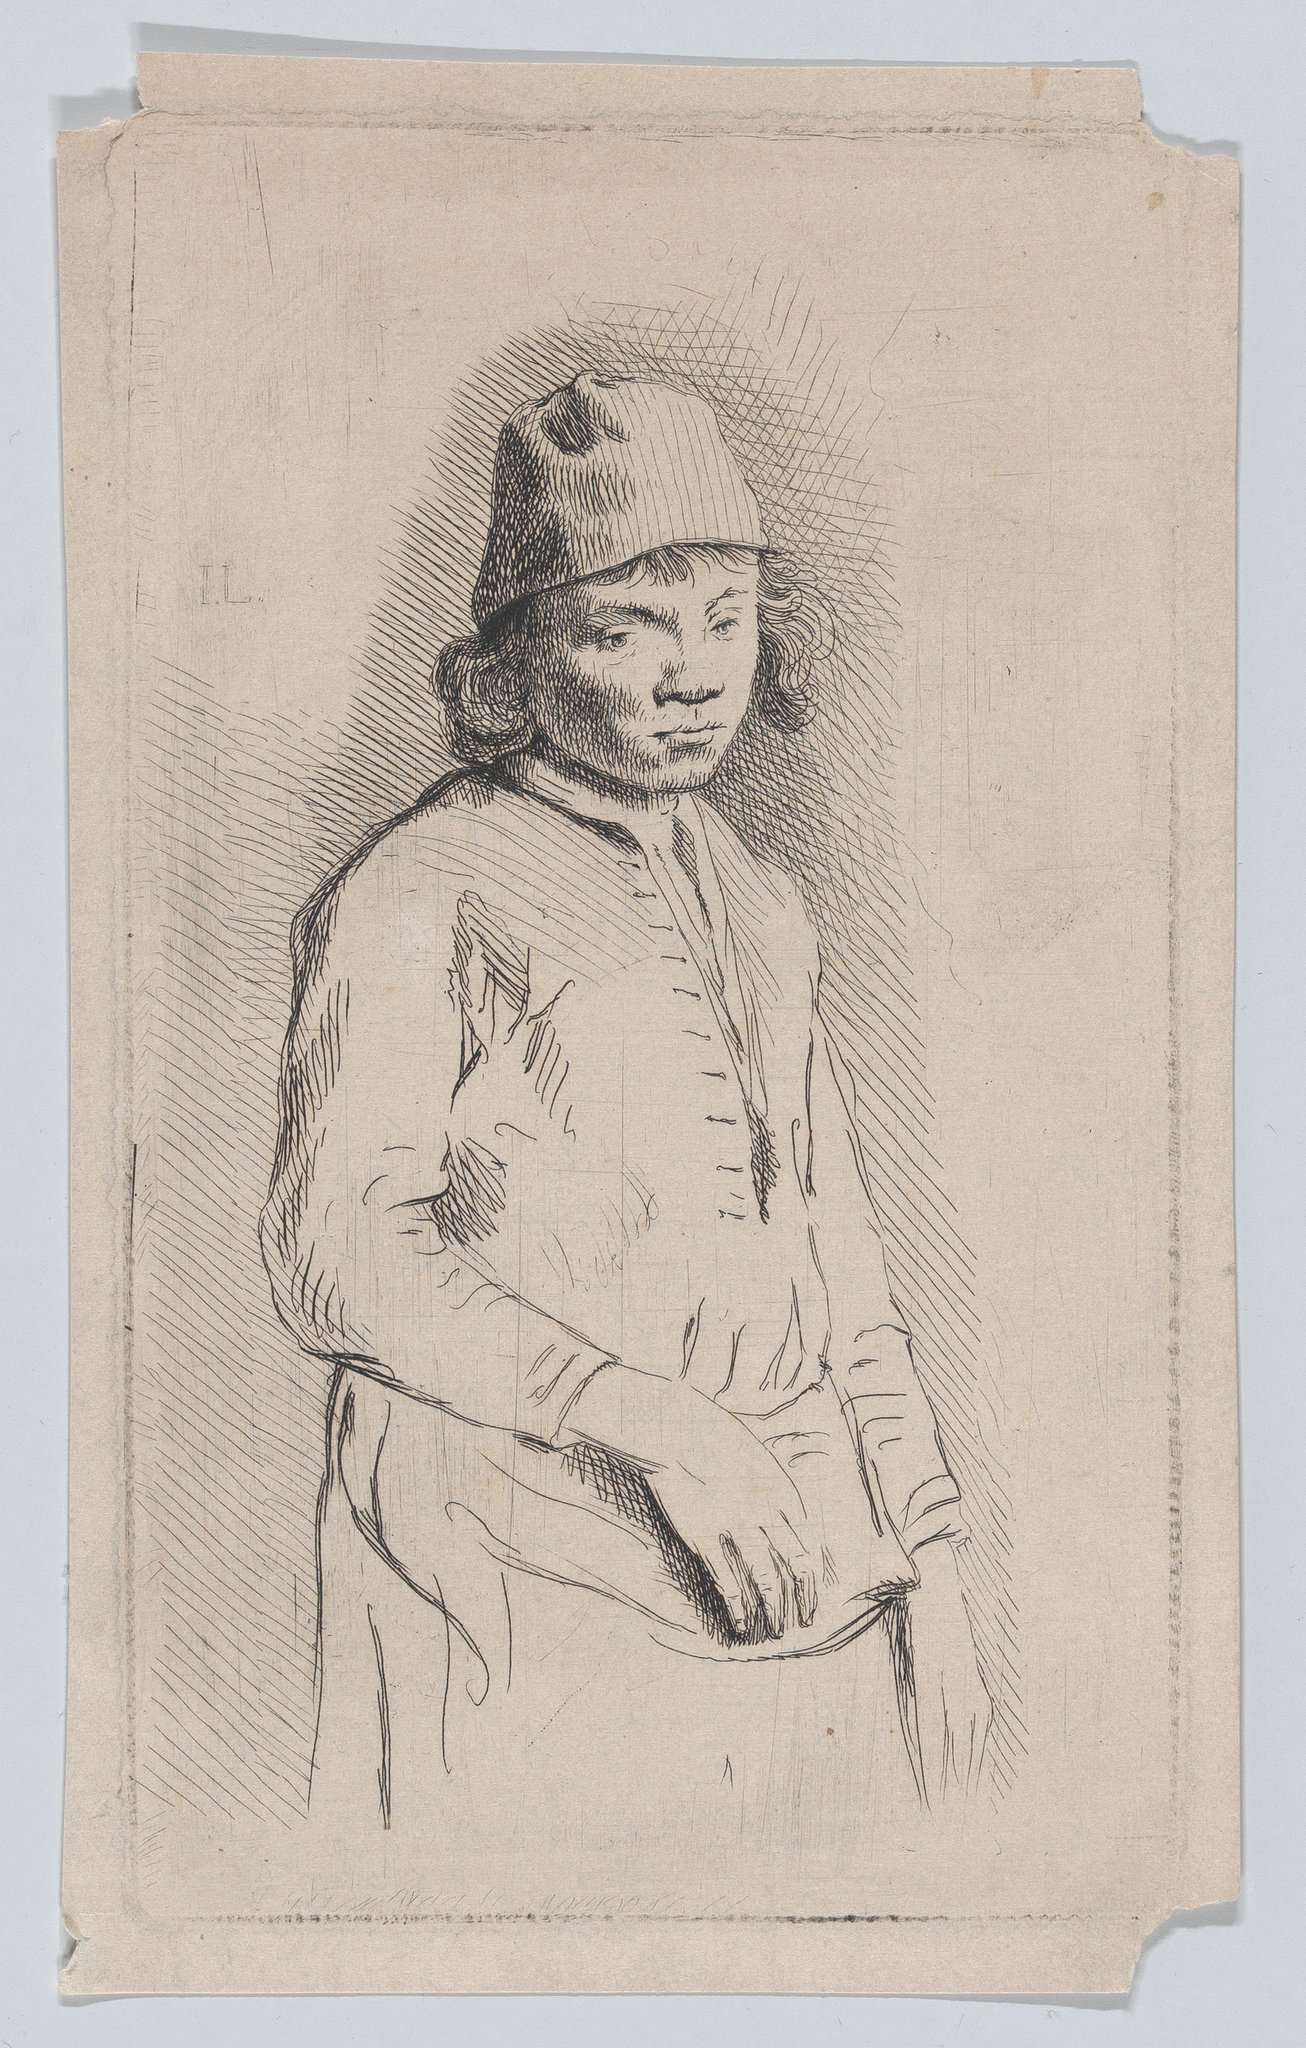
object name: print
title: Portrait of a boy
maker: Anonymous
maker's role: artist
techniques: etching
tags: boys,portraits